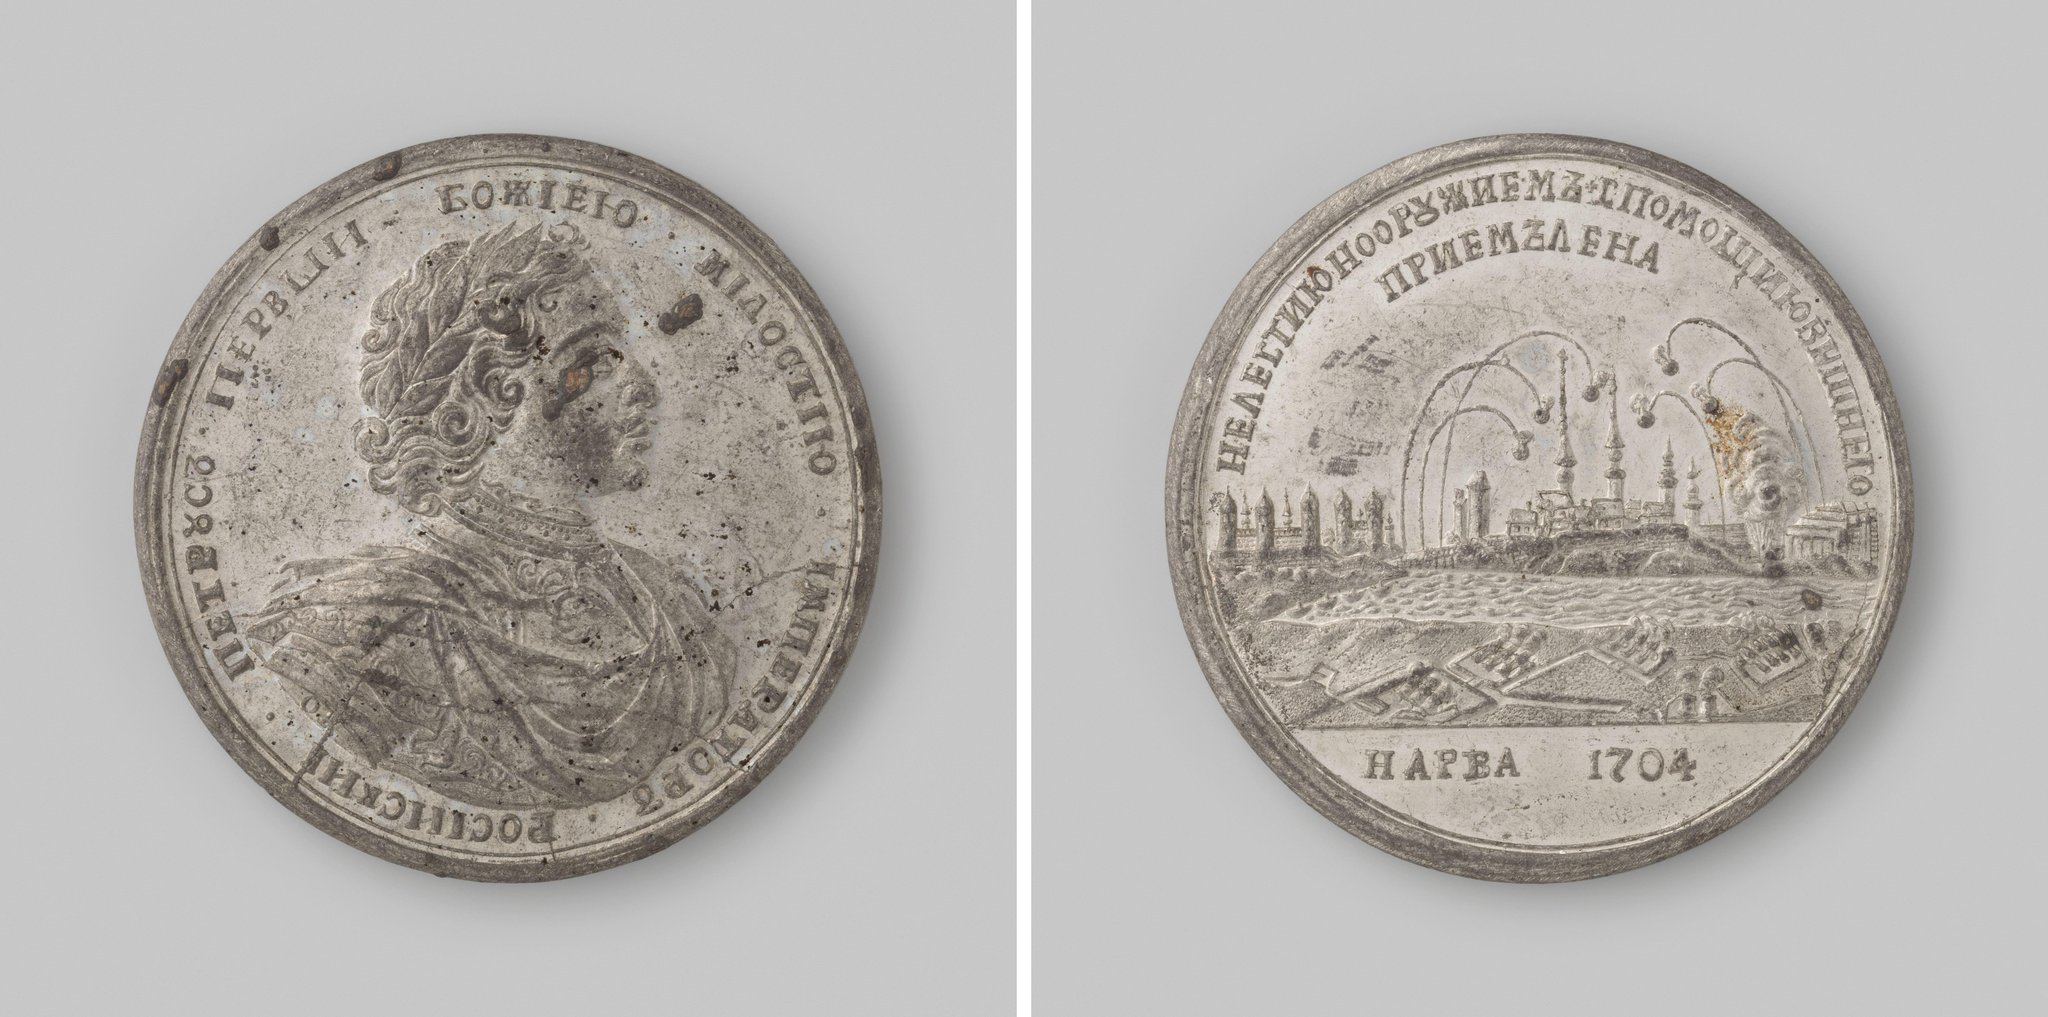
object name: history medal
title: Inname van Narwa door Rusland op Zweden 1704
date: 1704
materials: tin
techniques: striking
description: Tinnen penning, op de voorzijde het borstbeeld van Tsaar Peter de Grote naar rechts met omschrift, op de keerzijde het bombardement van Narva met dubbel omschrift en afsnedetekst.